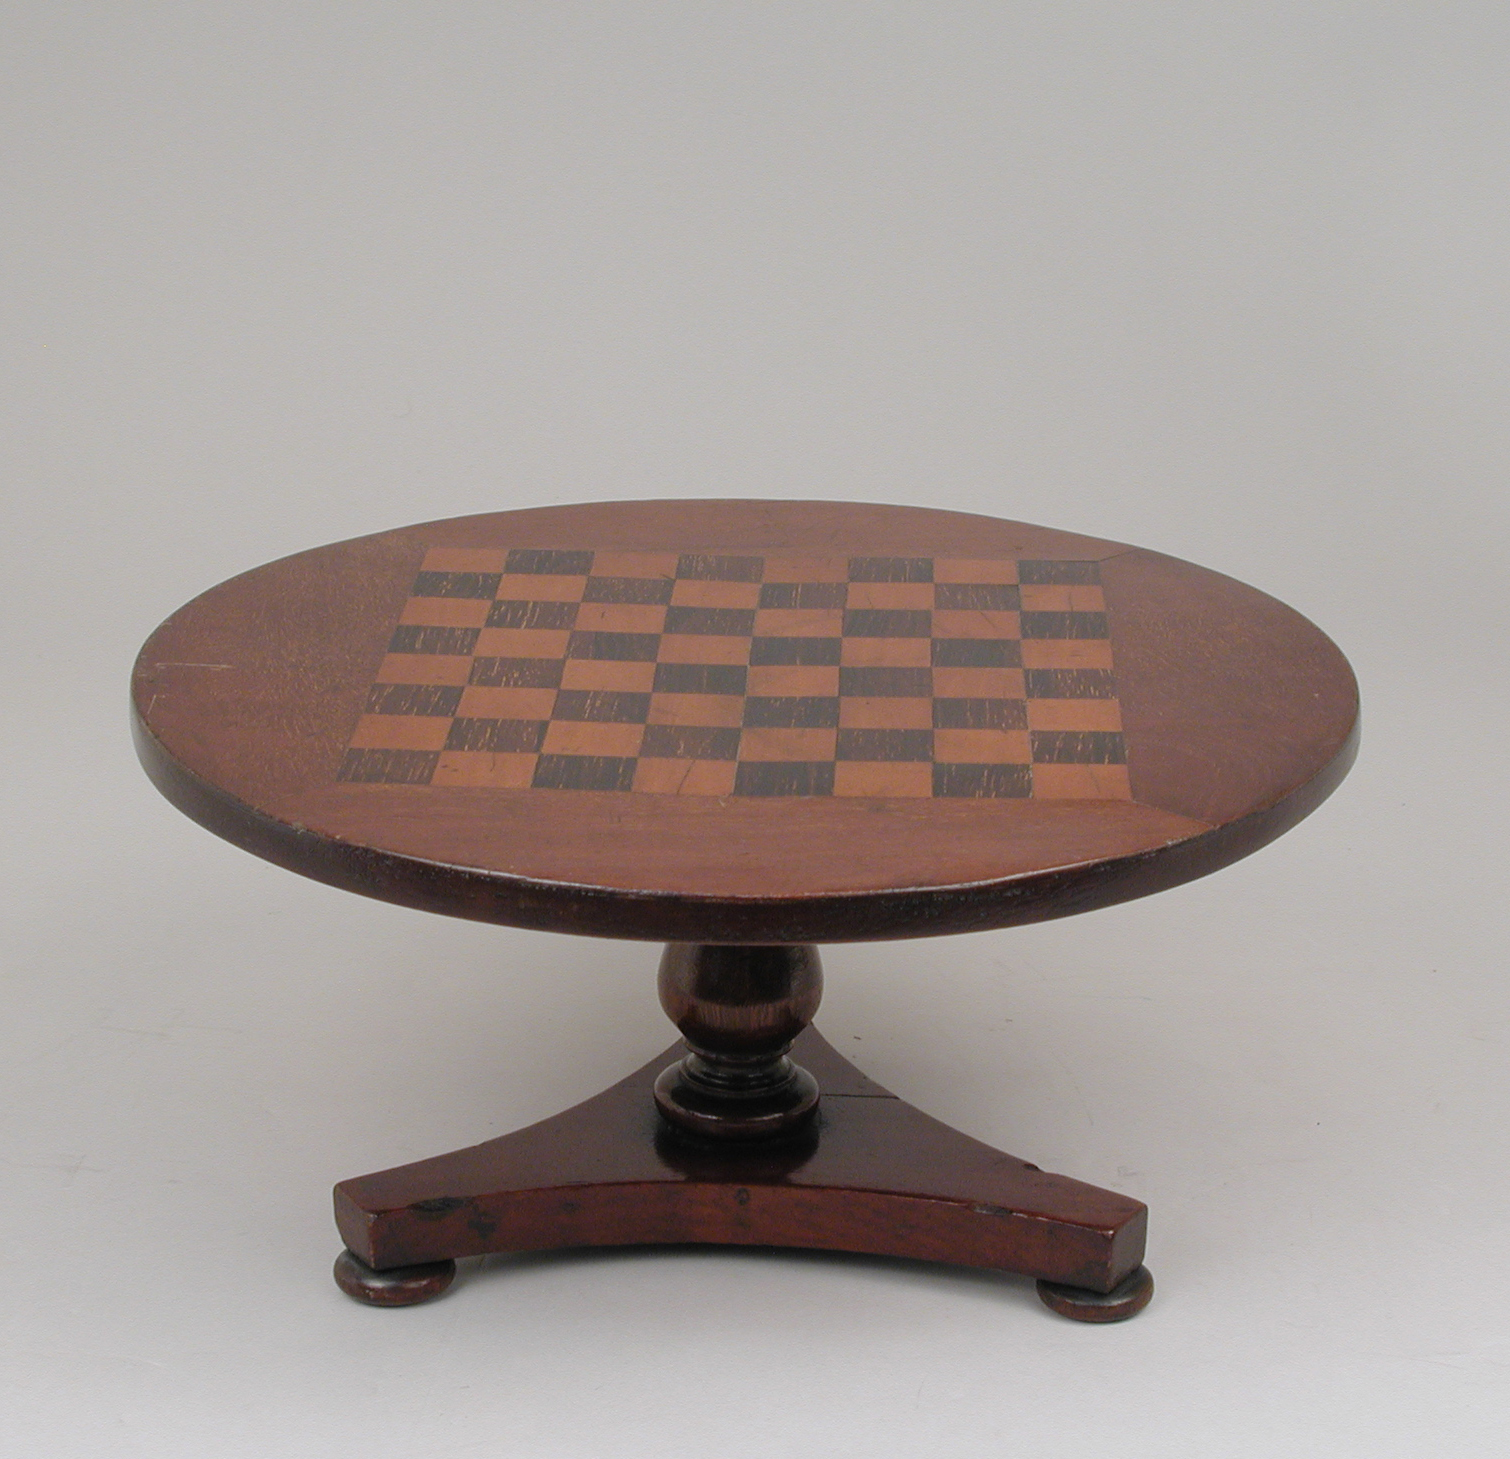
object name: chessboard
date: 1801-1900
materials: wood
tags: chess,games